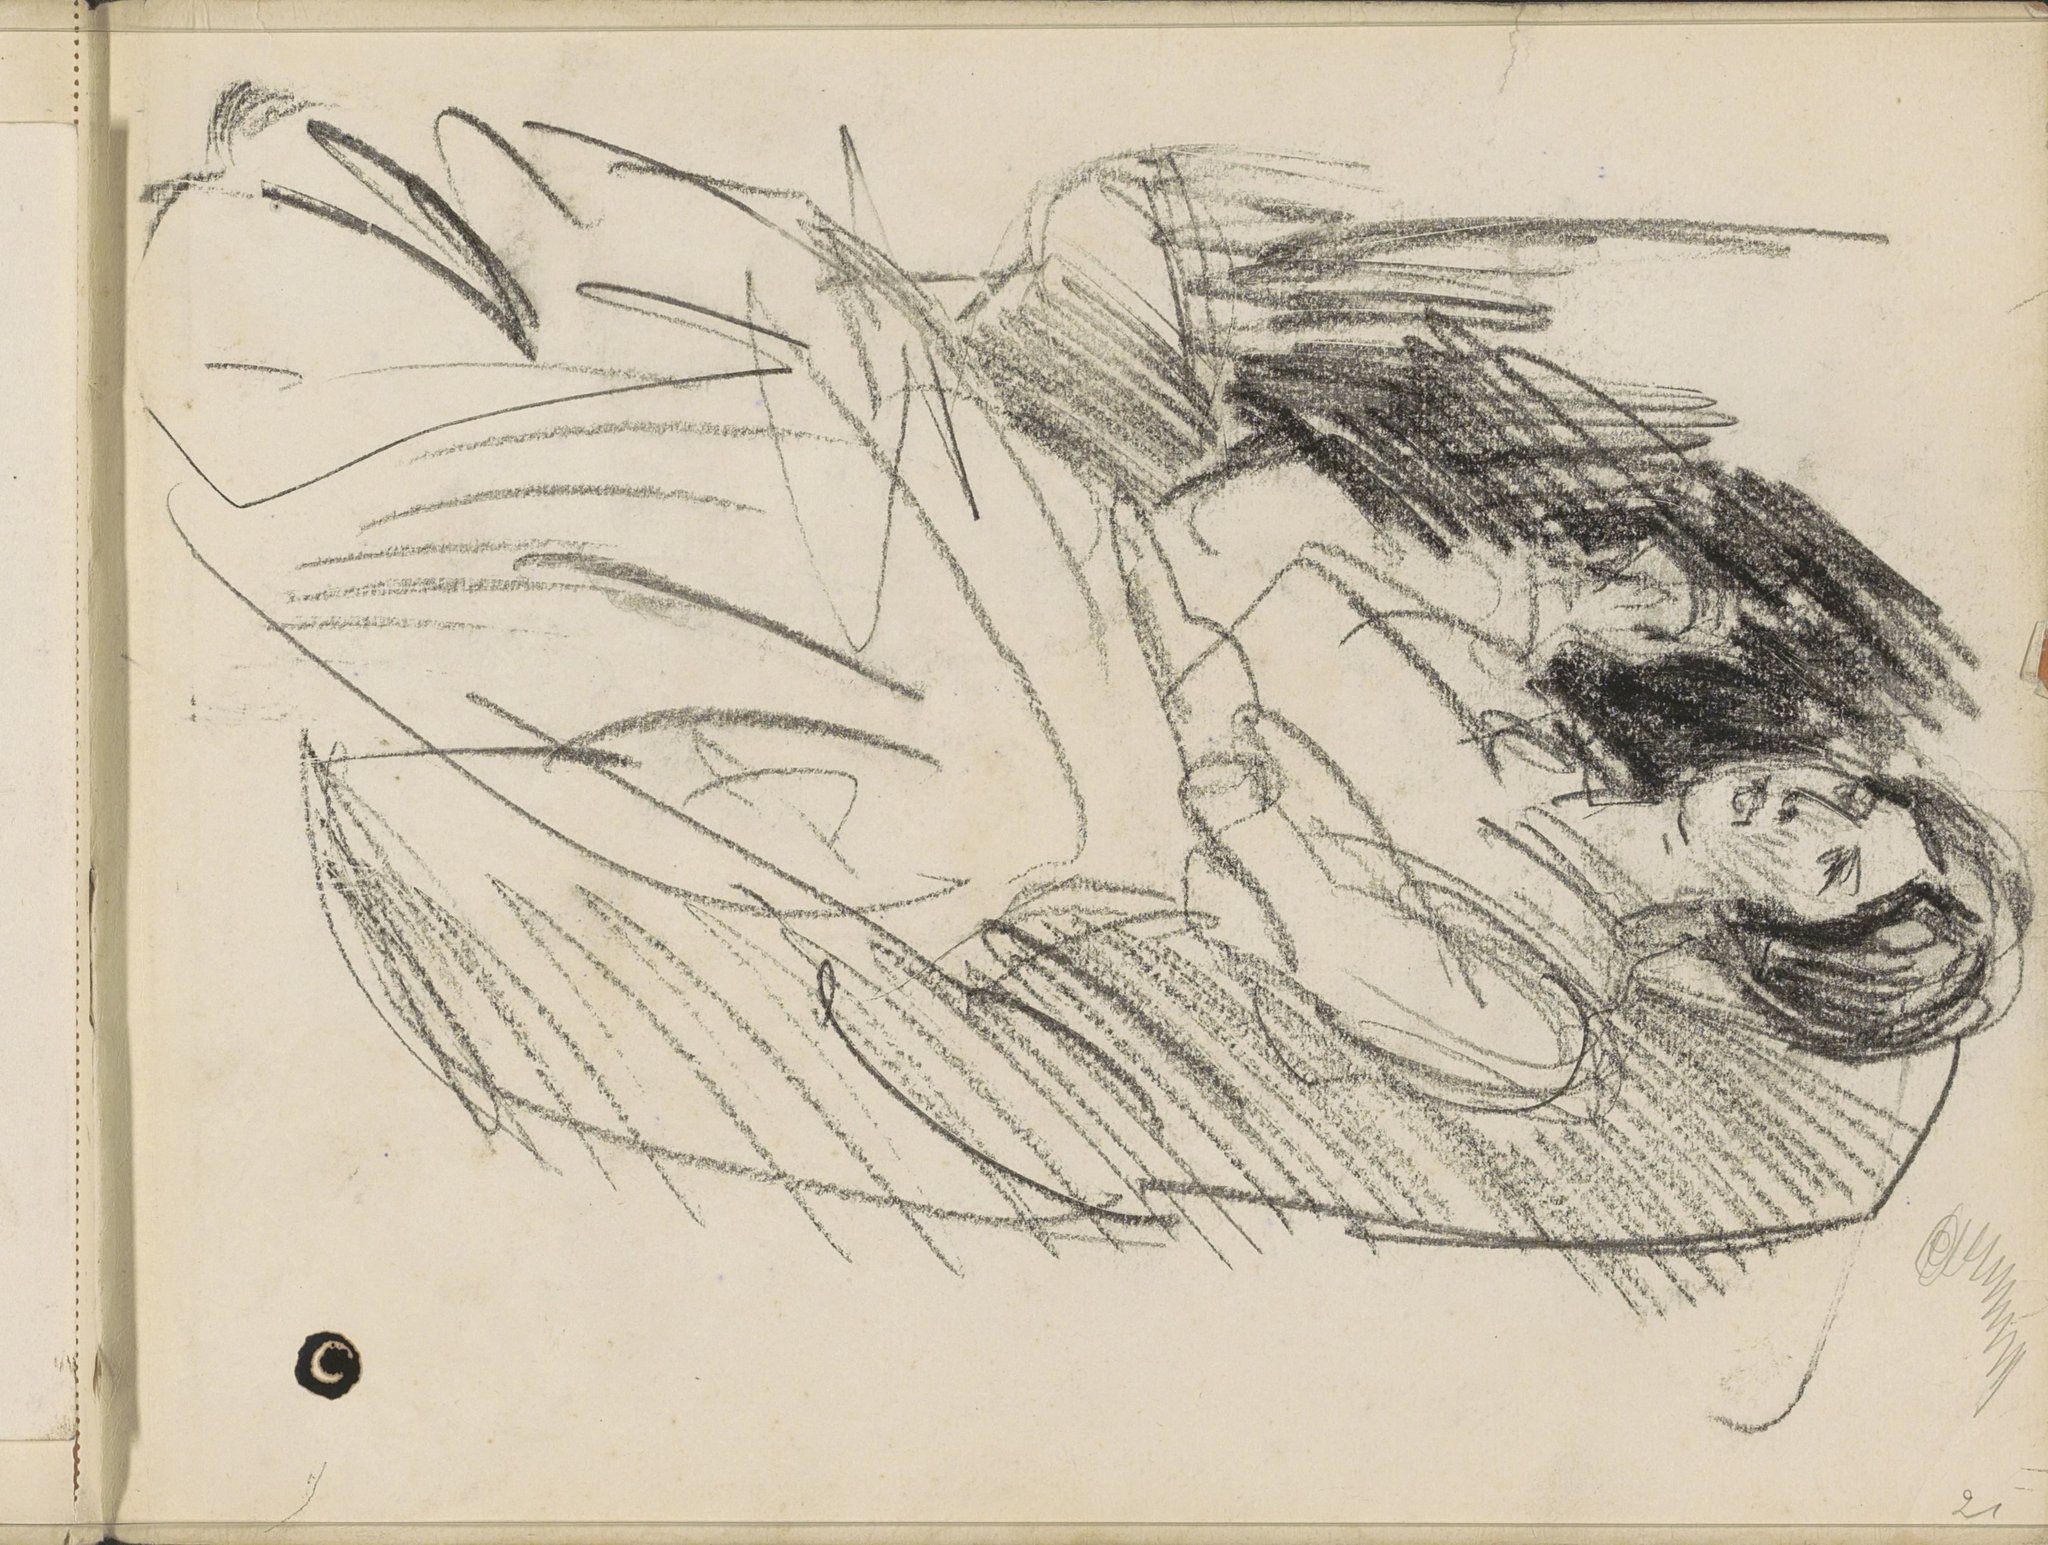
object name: sketchbook leaf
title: Zittende vrouw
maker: isaac israels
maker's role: draughtsman, painter, print maker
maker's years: 1865-1934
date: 1875-1934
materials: chalk, paper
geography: the hague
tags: adult woman (+ sitting)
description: Schutblad B, achterste schutblad, uit schetsboek XXIII met 20 bladen.